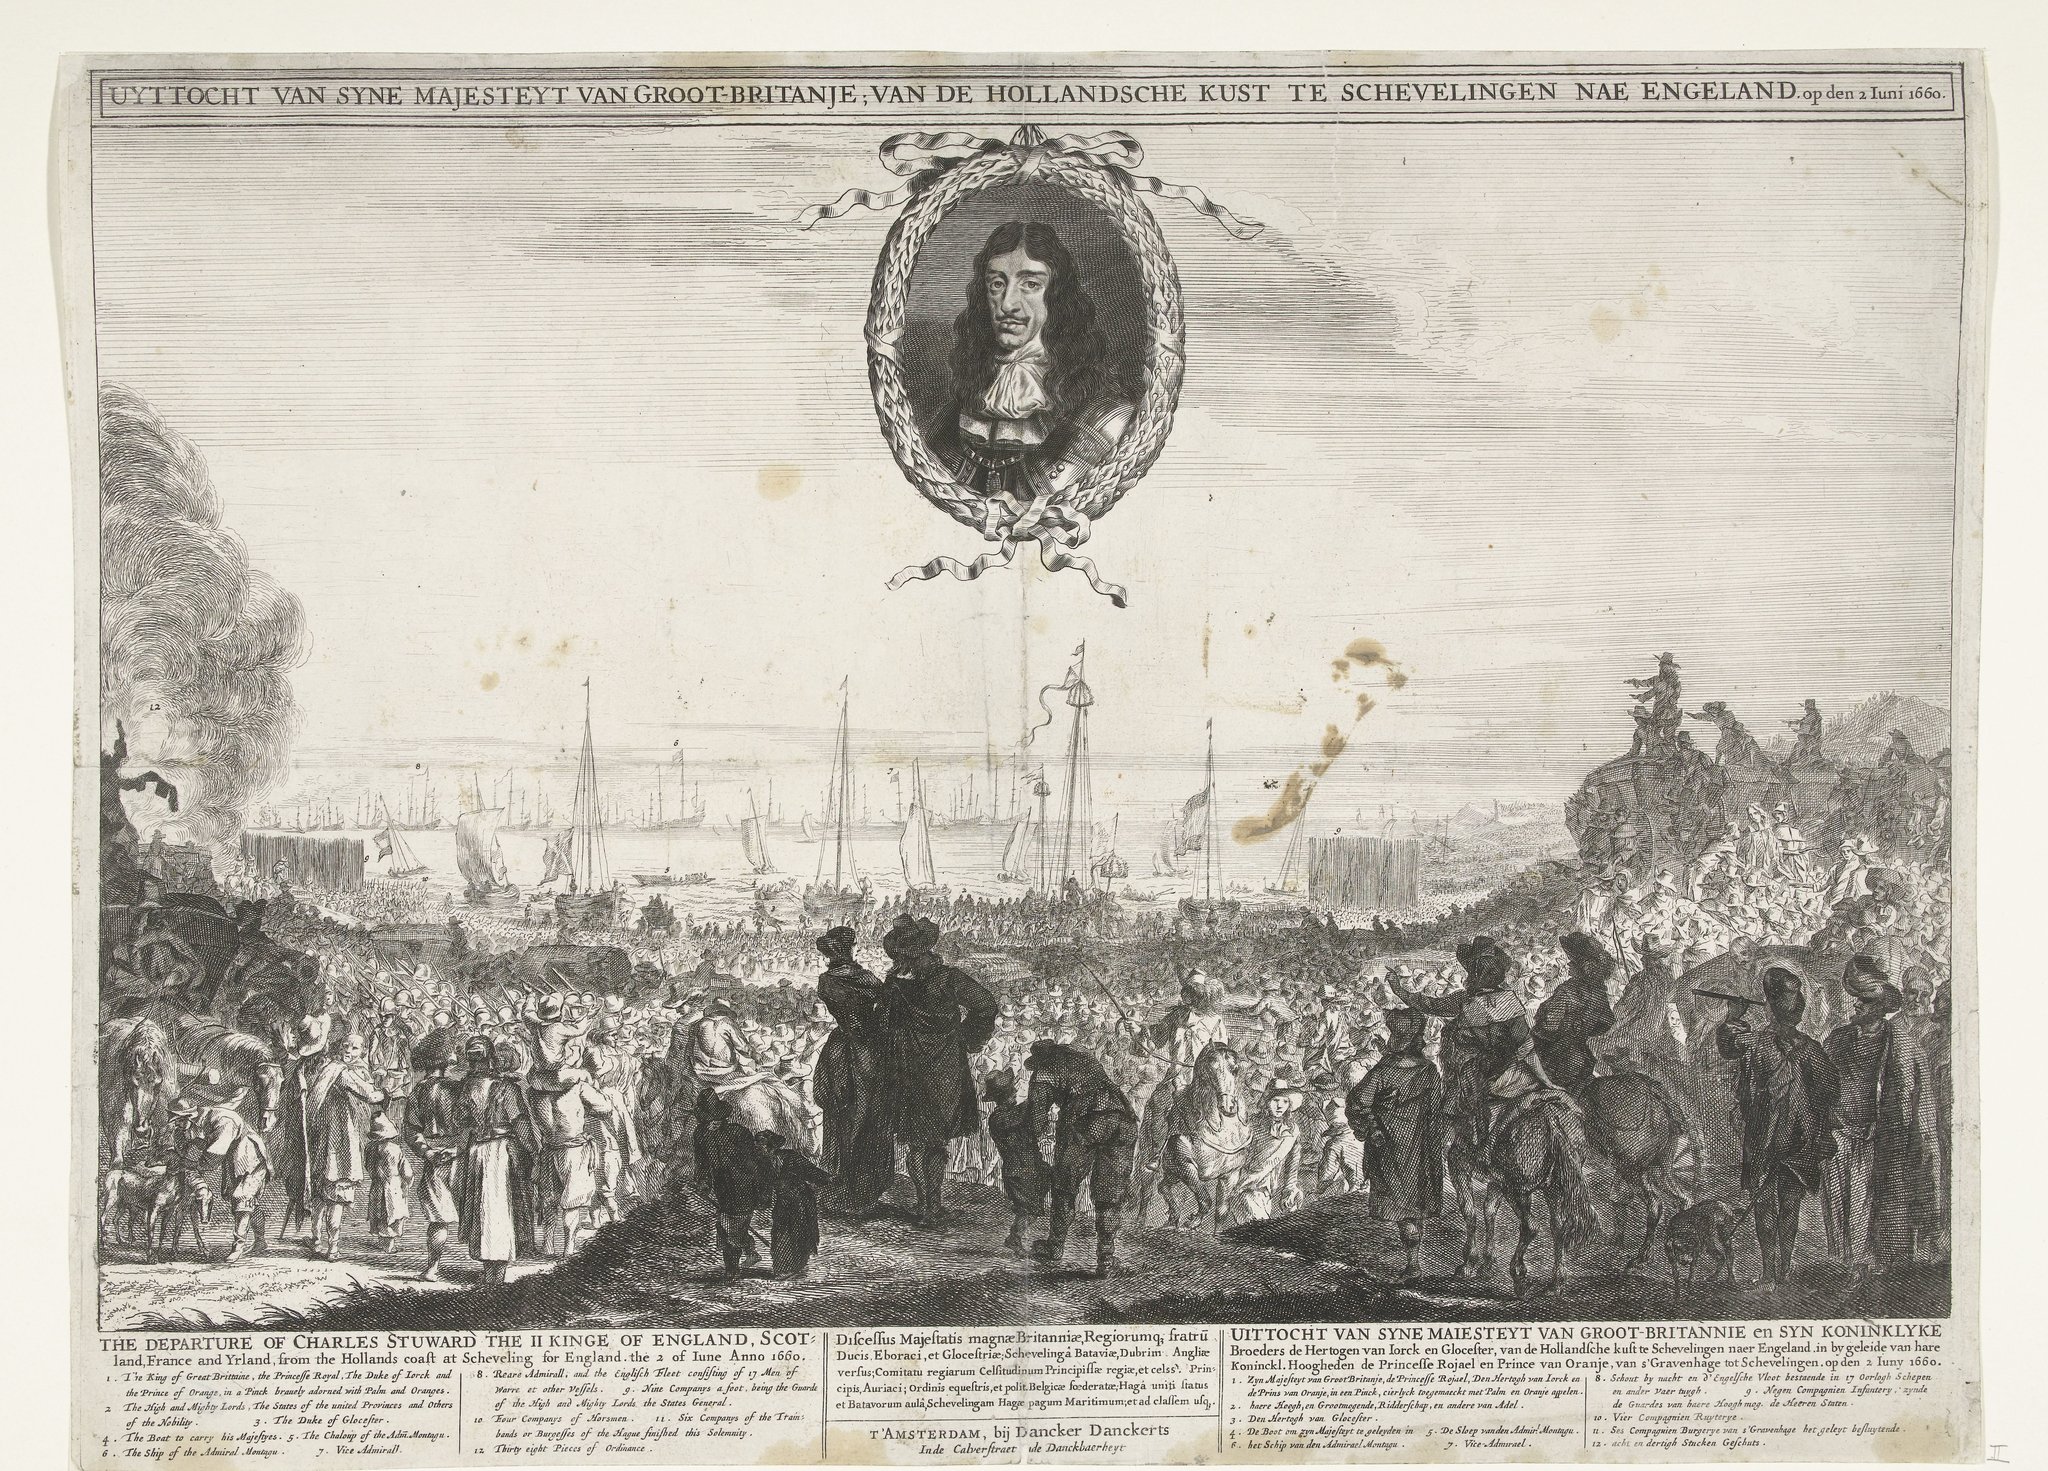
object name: print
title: Uyttocht van syne majesteyt van Groot-Britanje; van de Hollandsche kust te Schevelingen nae Engeland. op den 2 Juni 1660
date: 1660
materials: paper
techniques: engraving, etching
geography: amsterdam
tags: karel ii (koning van engeland), departure ~ travelling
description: Het vertrek van de Engelse koning Karel II vanuit Scheveningen naar Engeland, 2 juni 1660. Gezicht vanaf de duinen op het strand waar een menigte van toeschouwers kijkt naar het afscheid van de koning staande op de jacht die hem naar zijn schip zal brengen. In het onderschrift de legenda's 1-12 in het Engels en Nederlands. De staat met het portret van Karel II.